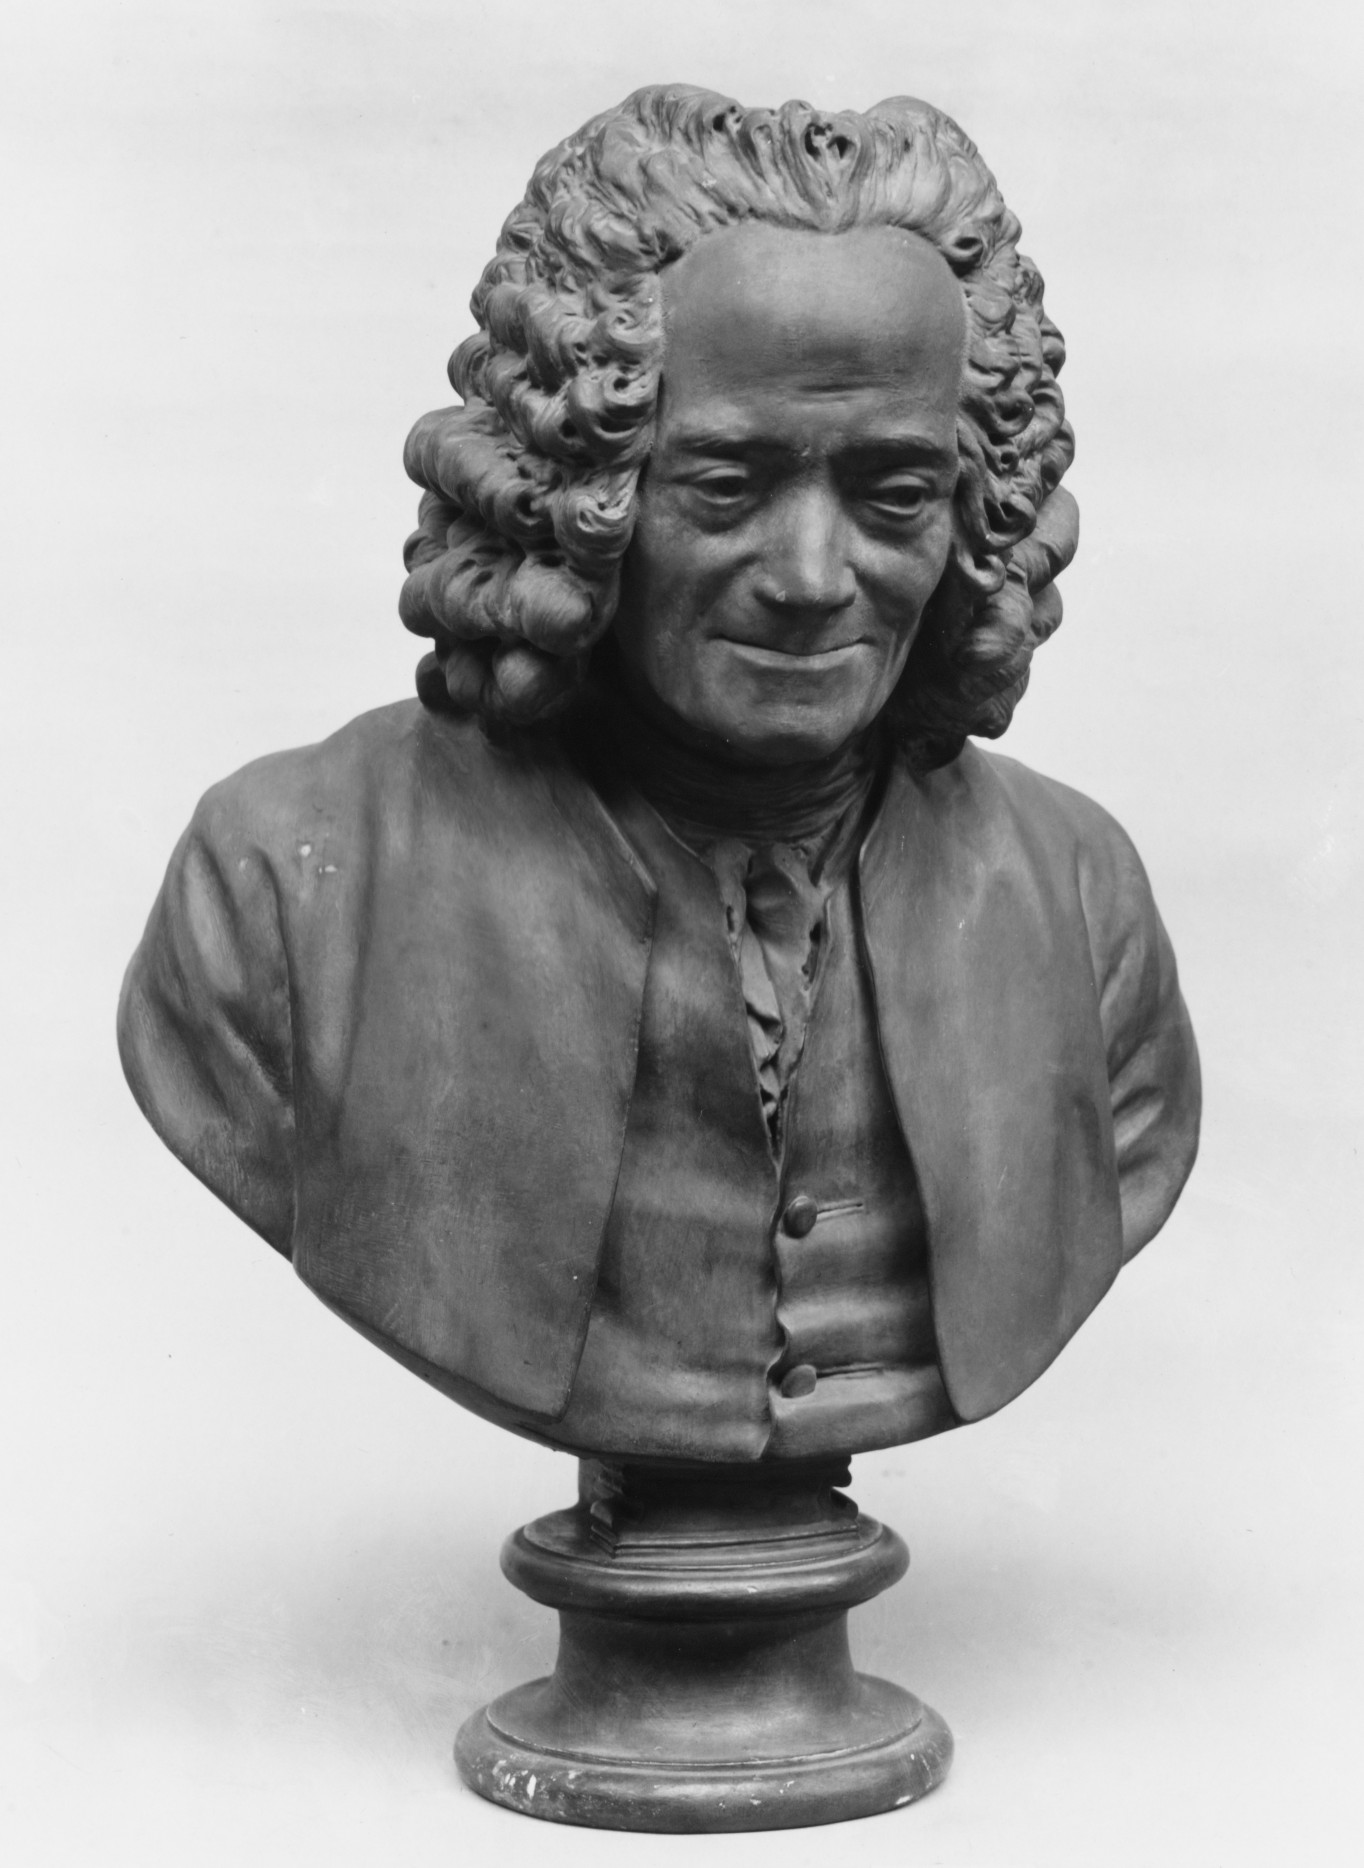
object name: bust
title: Voltaire (Marie François Arouet, 1694–1778)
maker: jean antoine houdon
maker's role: artist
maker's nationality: french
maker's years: 1741-1828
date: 1767-1800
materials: plaster, wood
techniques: gilding, painting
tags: men,portraits,authors